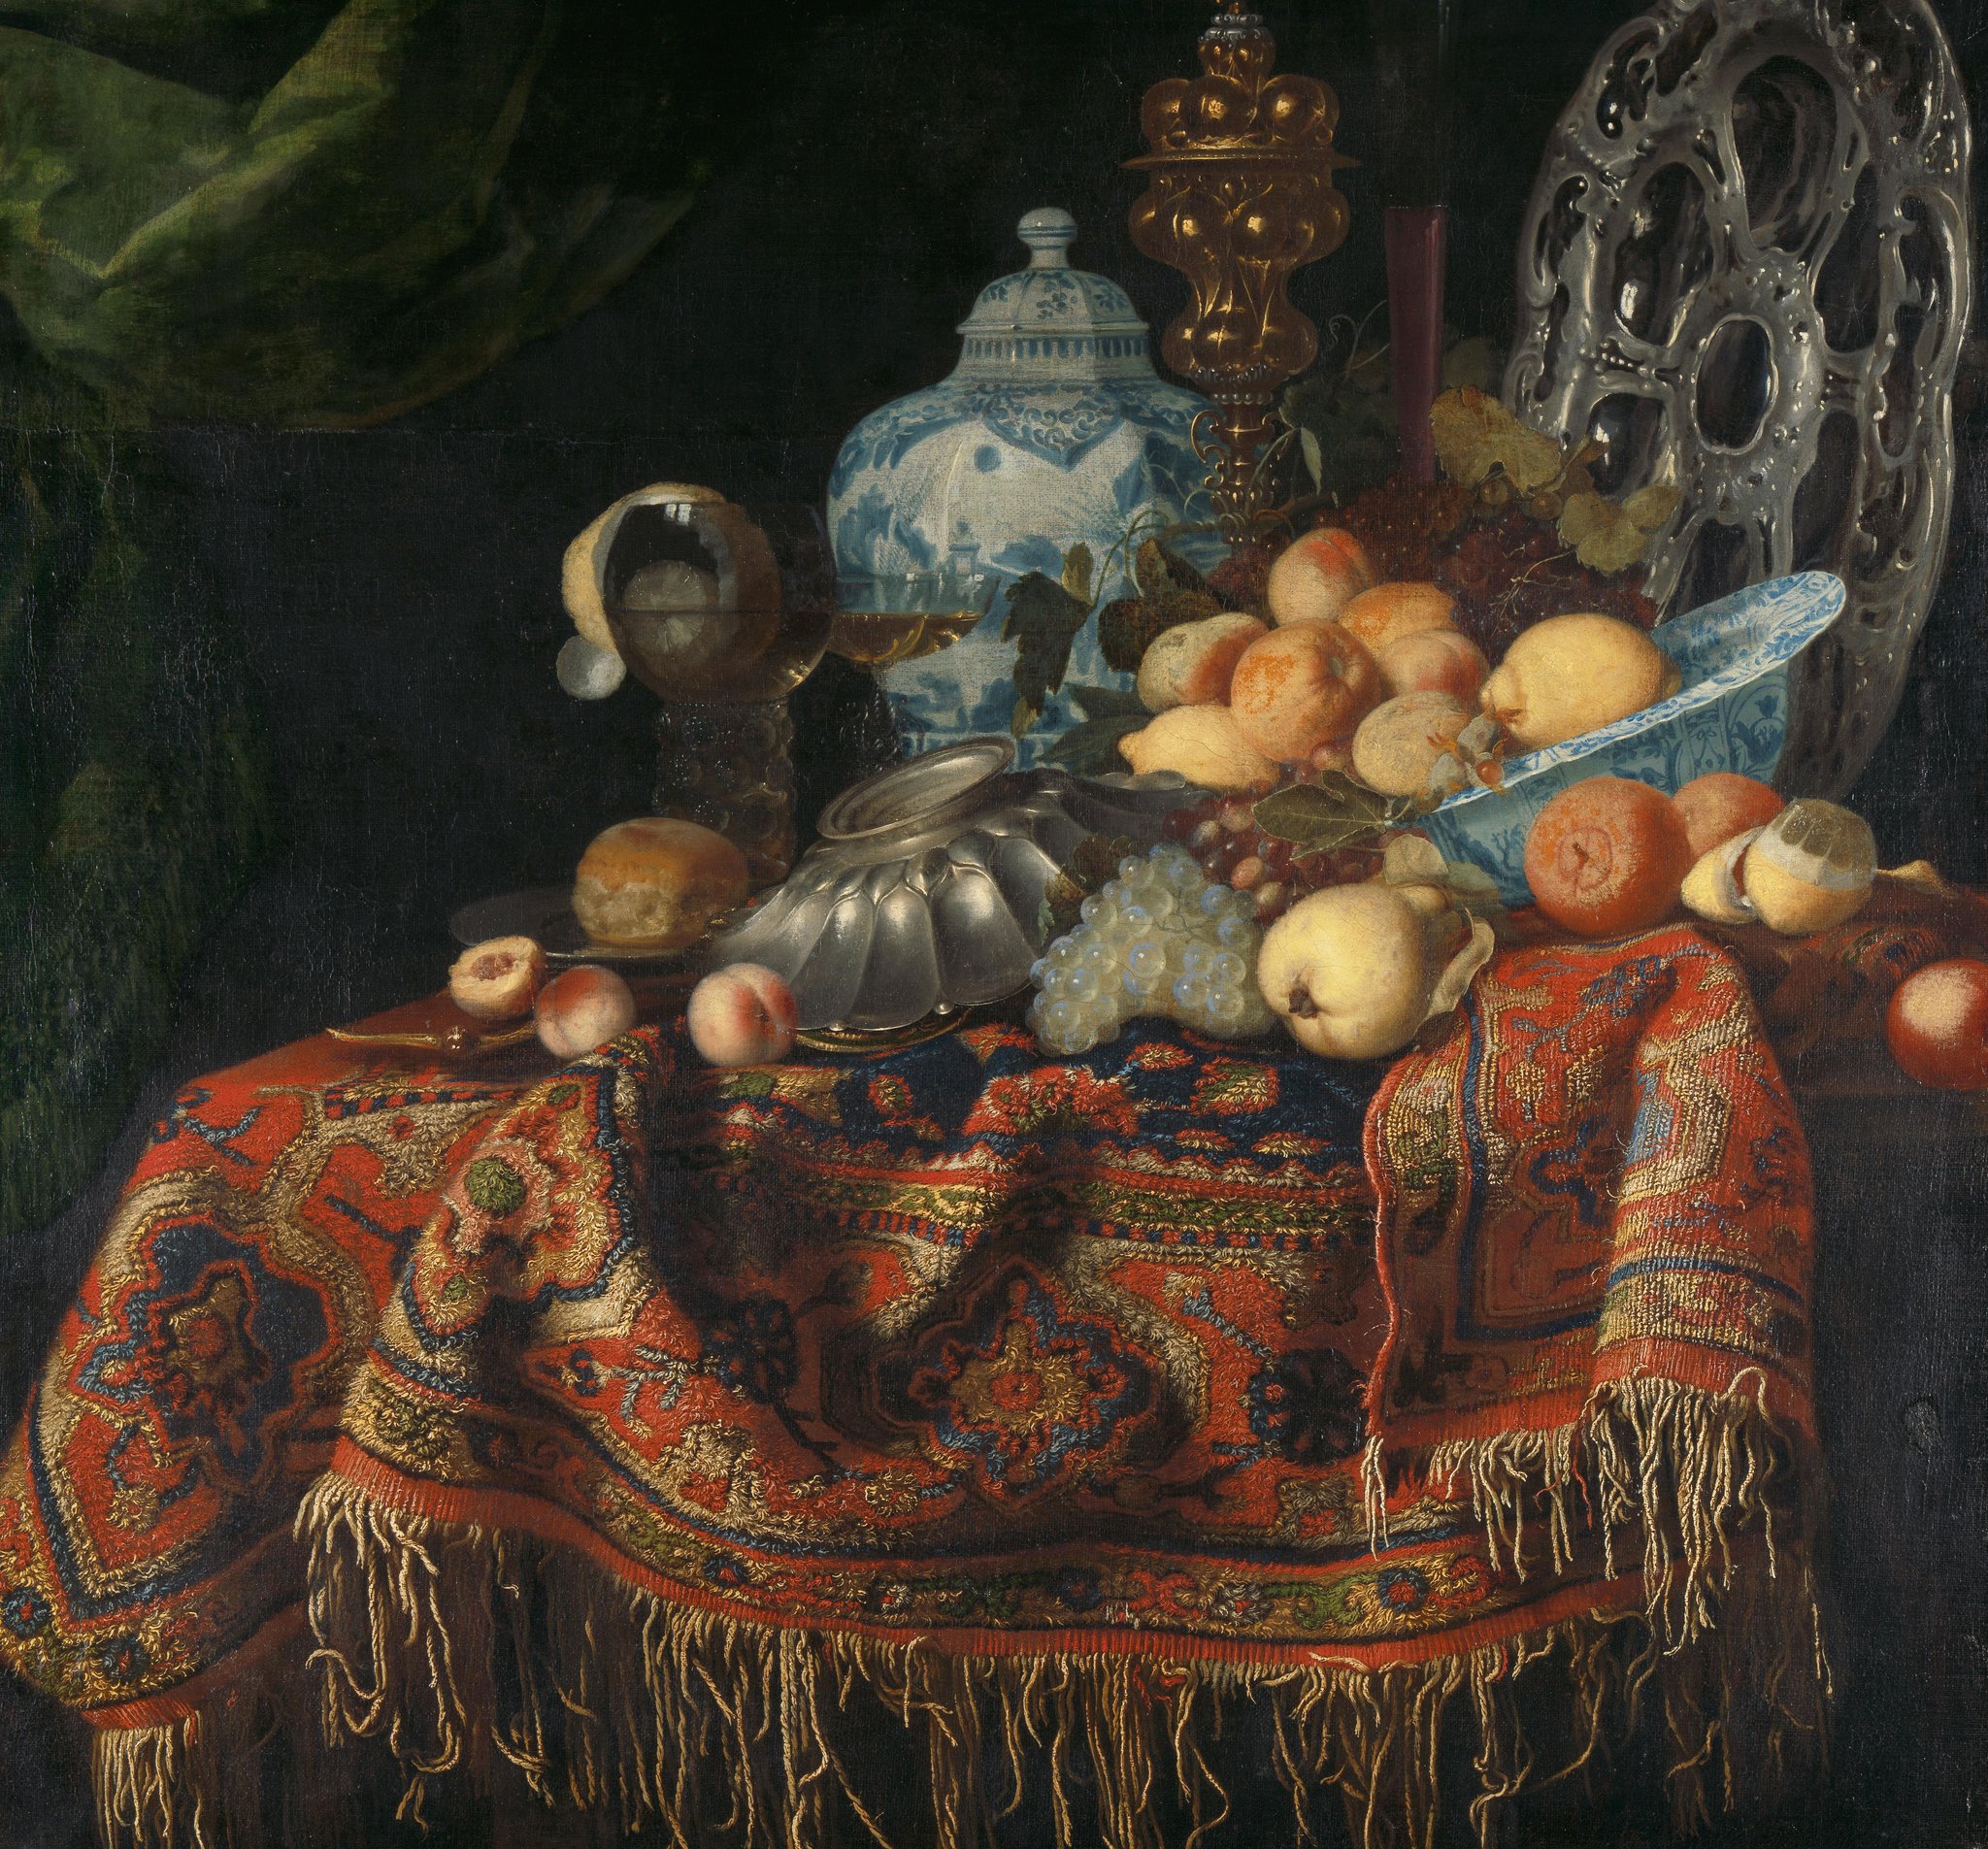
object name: painting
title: Still Life with Fruit, Plates and Dishes on a Turkey Carpet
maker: simon luttichuys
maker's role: painter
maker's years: 1610-1661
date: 1650-1680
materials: canvas, oil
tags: fruits: apple, fruits: grape, fruits: peach, table-cloth, laid table: table-ware, table-decoration, etc., foodstuffs; still life of foodstuffs, fruits: lemon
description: Stilleven met vruchten en vaatwerk op een Smyrna kleed. Op een tafel bedekt met een Oosters tapijt liggen een Wan Li-schaal met appels en citroenen, zilveren schalen, een gouden pronkbeker, een brood op een tinnen bord, een roemer met wijn waarin een geschilde citroen hangt, verder druiven en een peer. Achteraan staat een grote porseleinen vaas of pot.